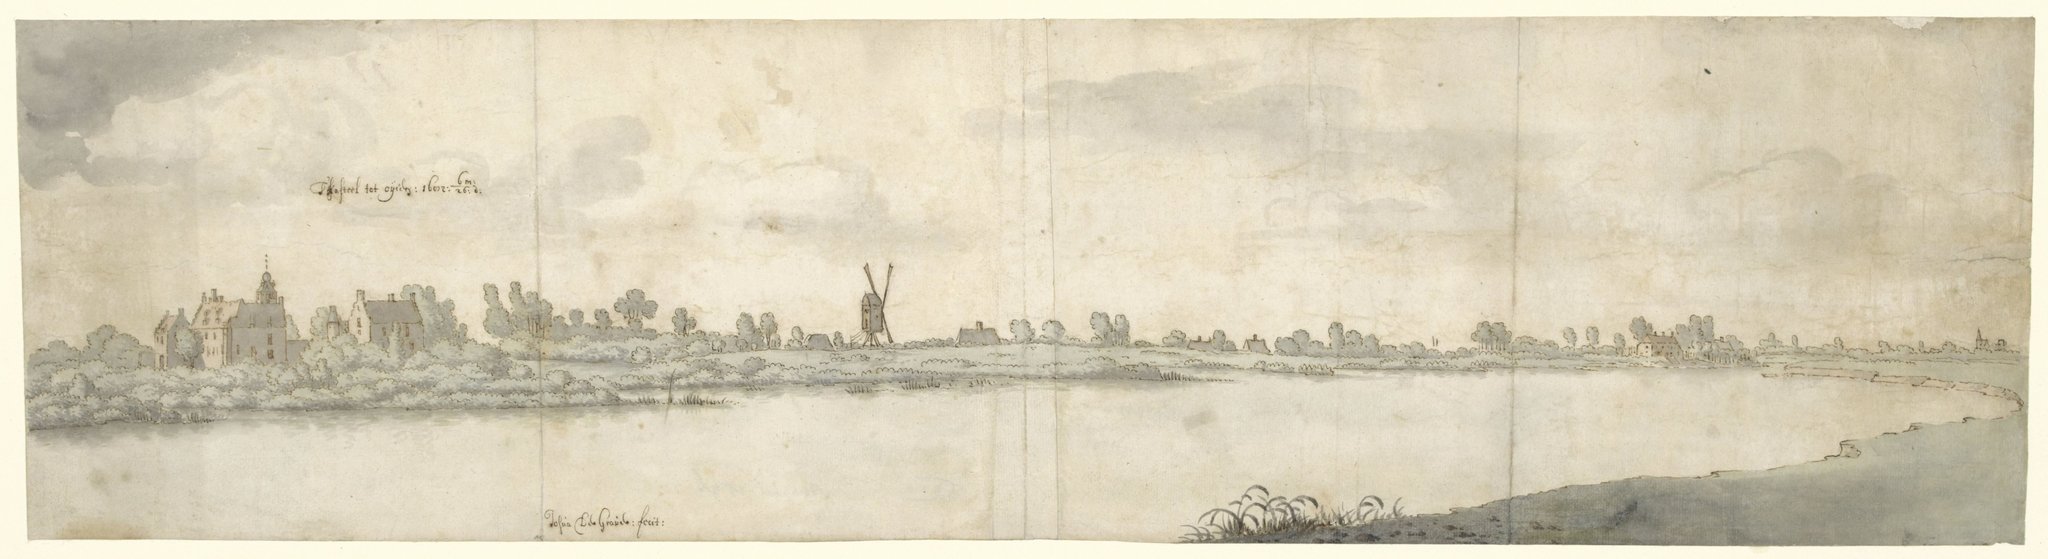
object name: drawing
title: View of Kasteel Ooij, near Nijmegen, North Brabant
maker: josua de grave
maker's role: draughtsman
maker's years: 1645-1712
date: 1682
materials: ink, paper, watercolor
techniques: brush, pen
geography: oijen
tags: castle, river, farm or solitary house in landscape